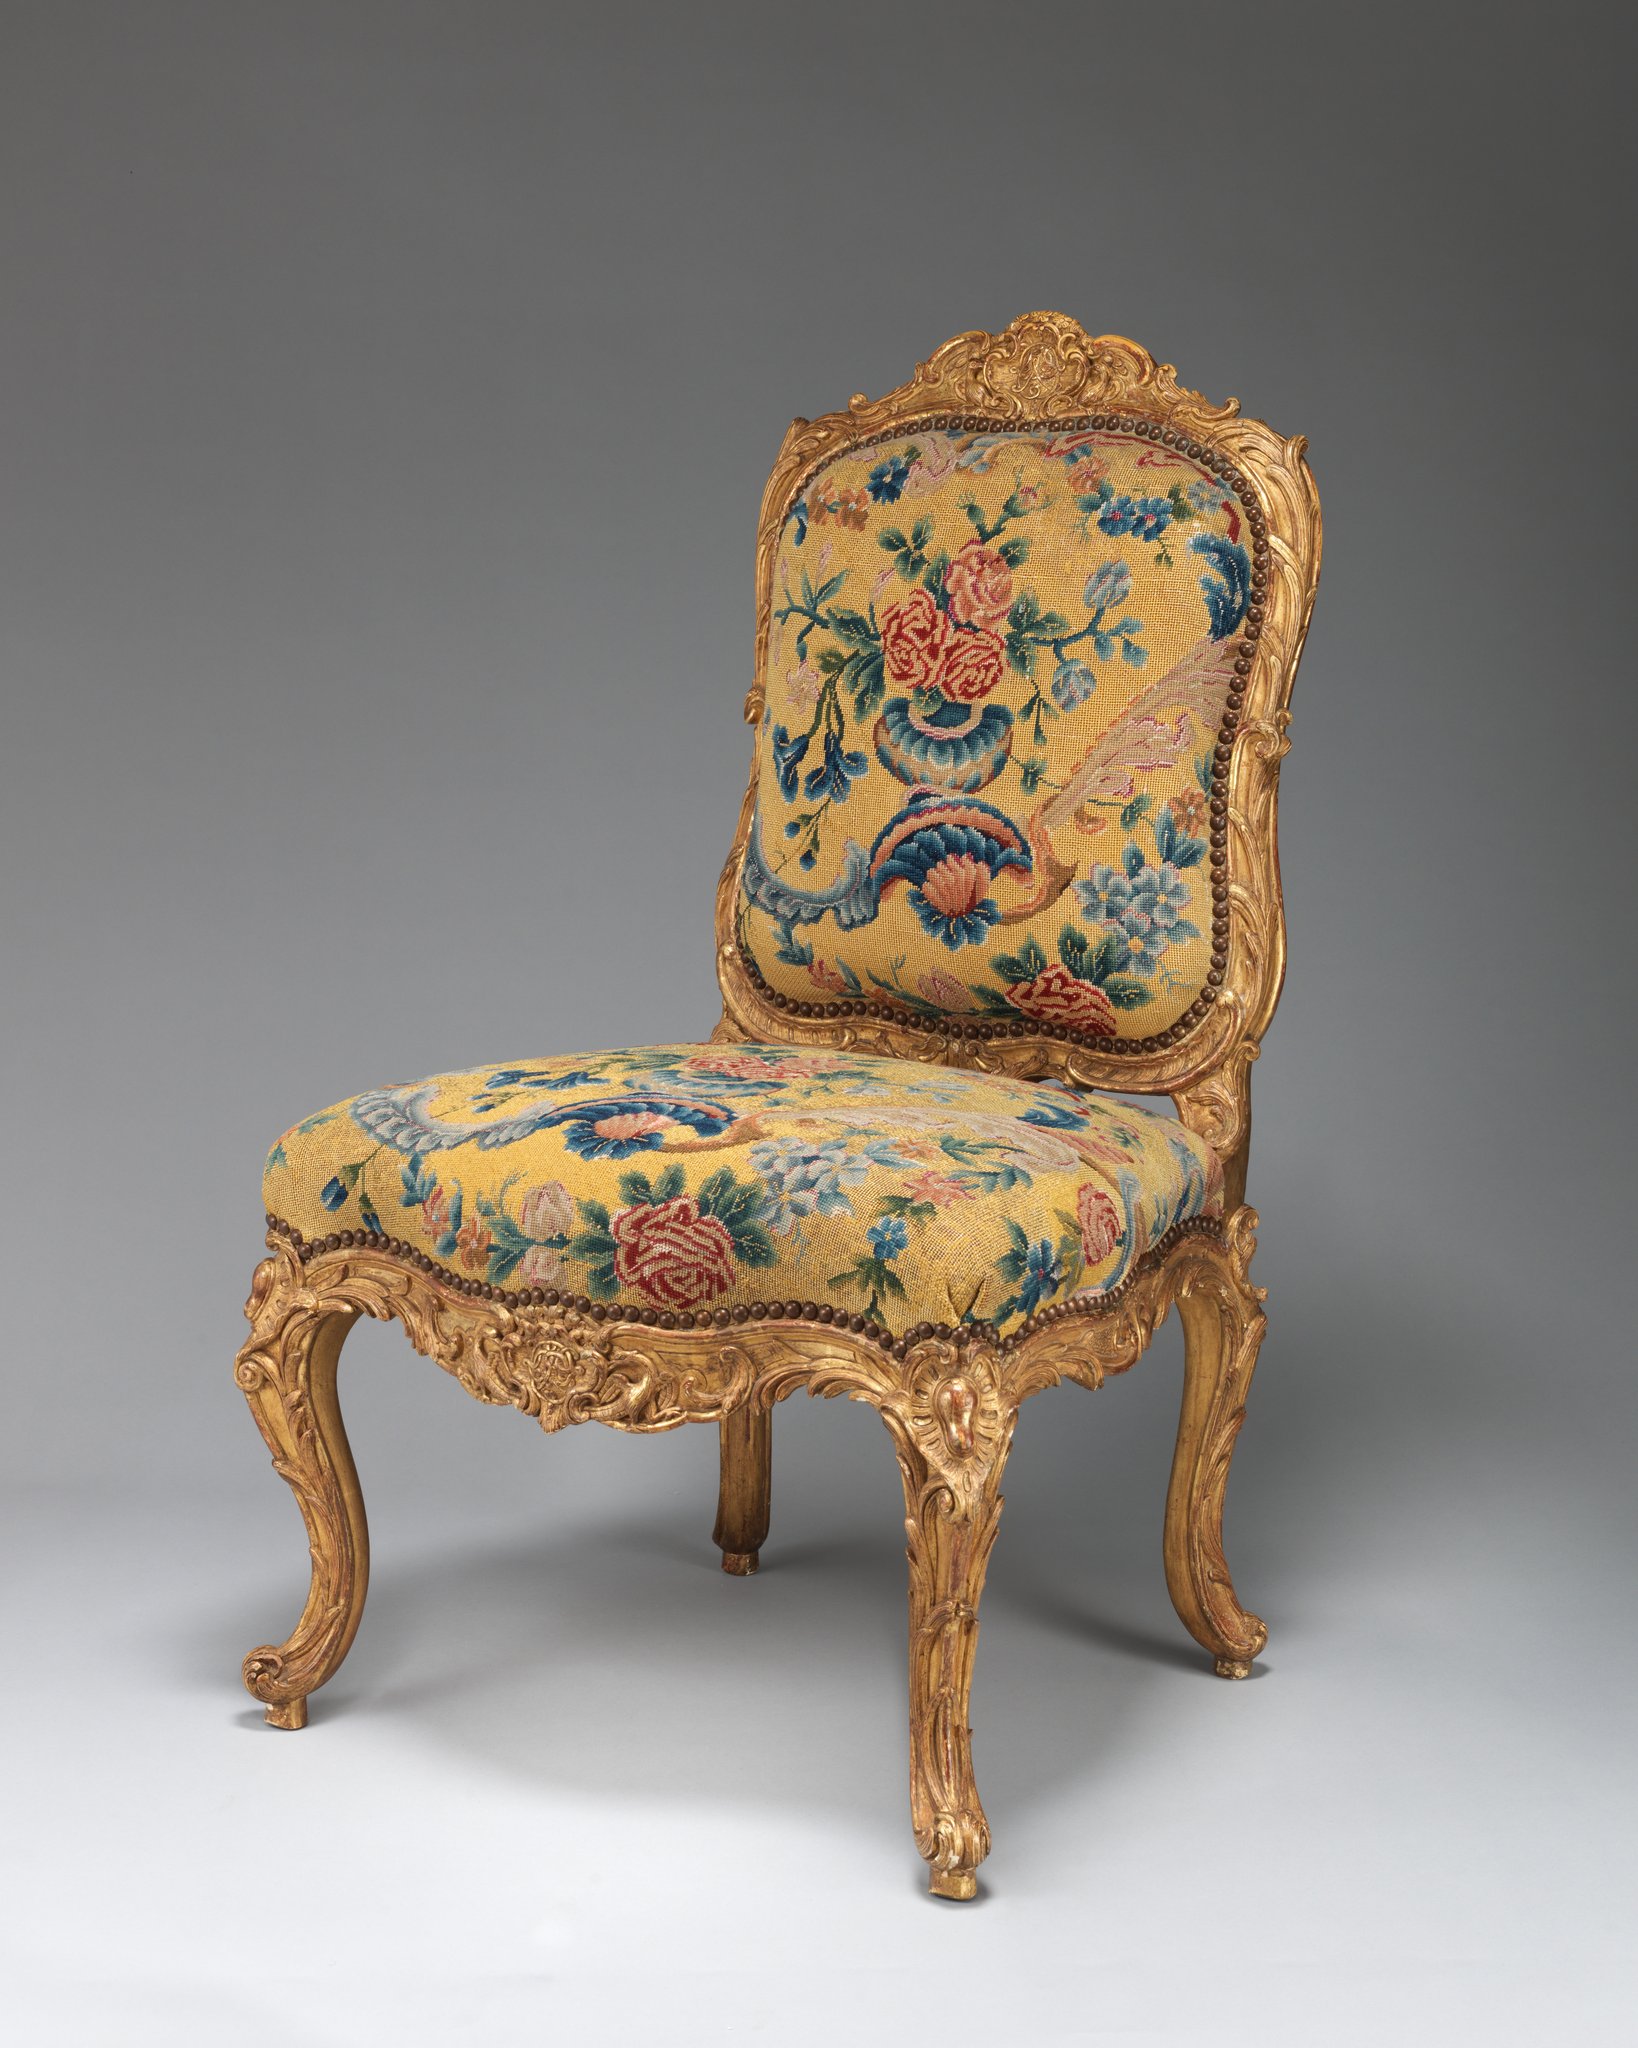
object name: chair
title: Chair (chaise à la Reine) (one of a set of four)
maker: jean-baptiste i tilliard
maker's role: maker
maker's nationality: french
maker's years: 1686-1766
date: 1745-1750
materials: wood, brass, coral, velvet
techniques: carving, gilding